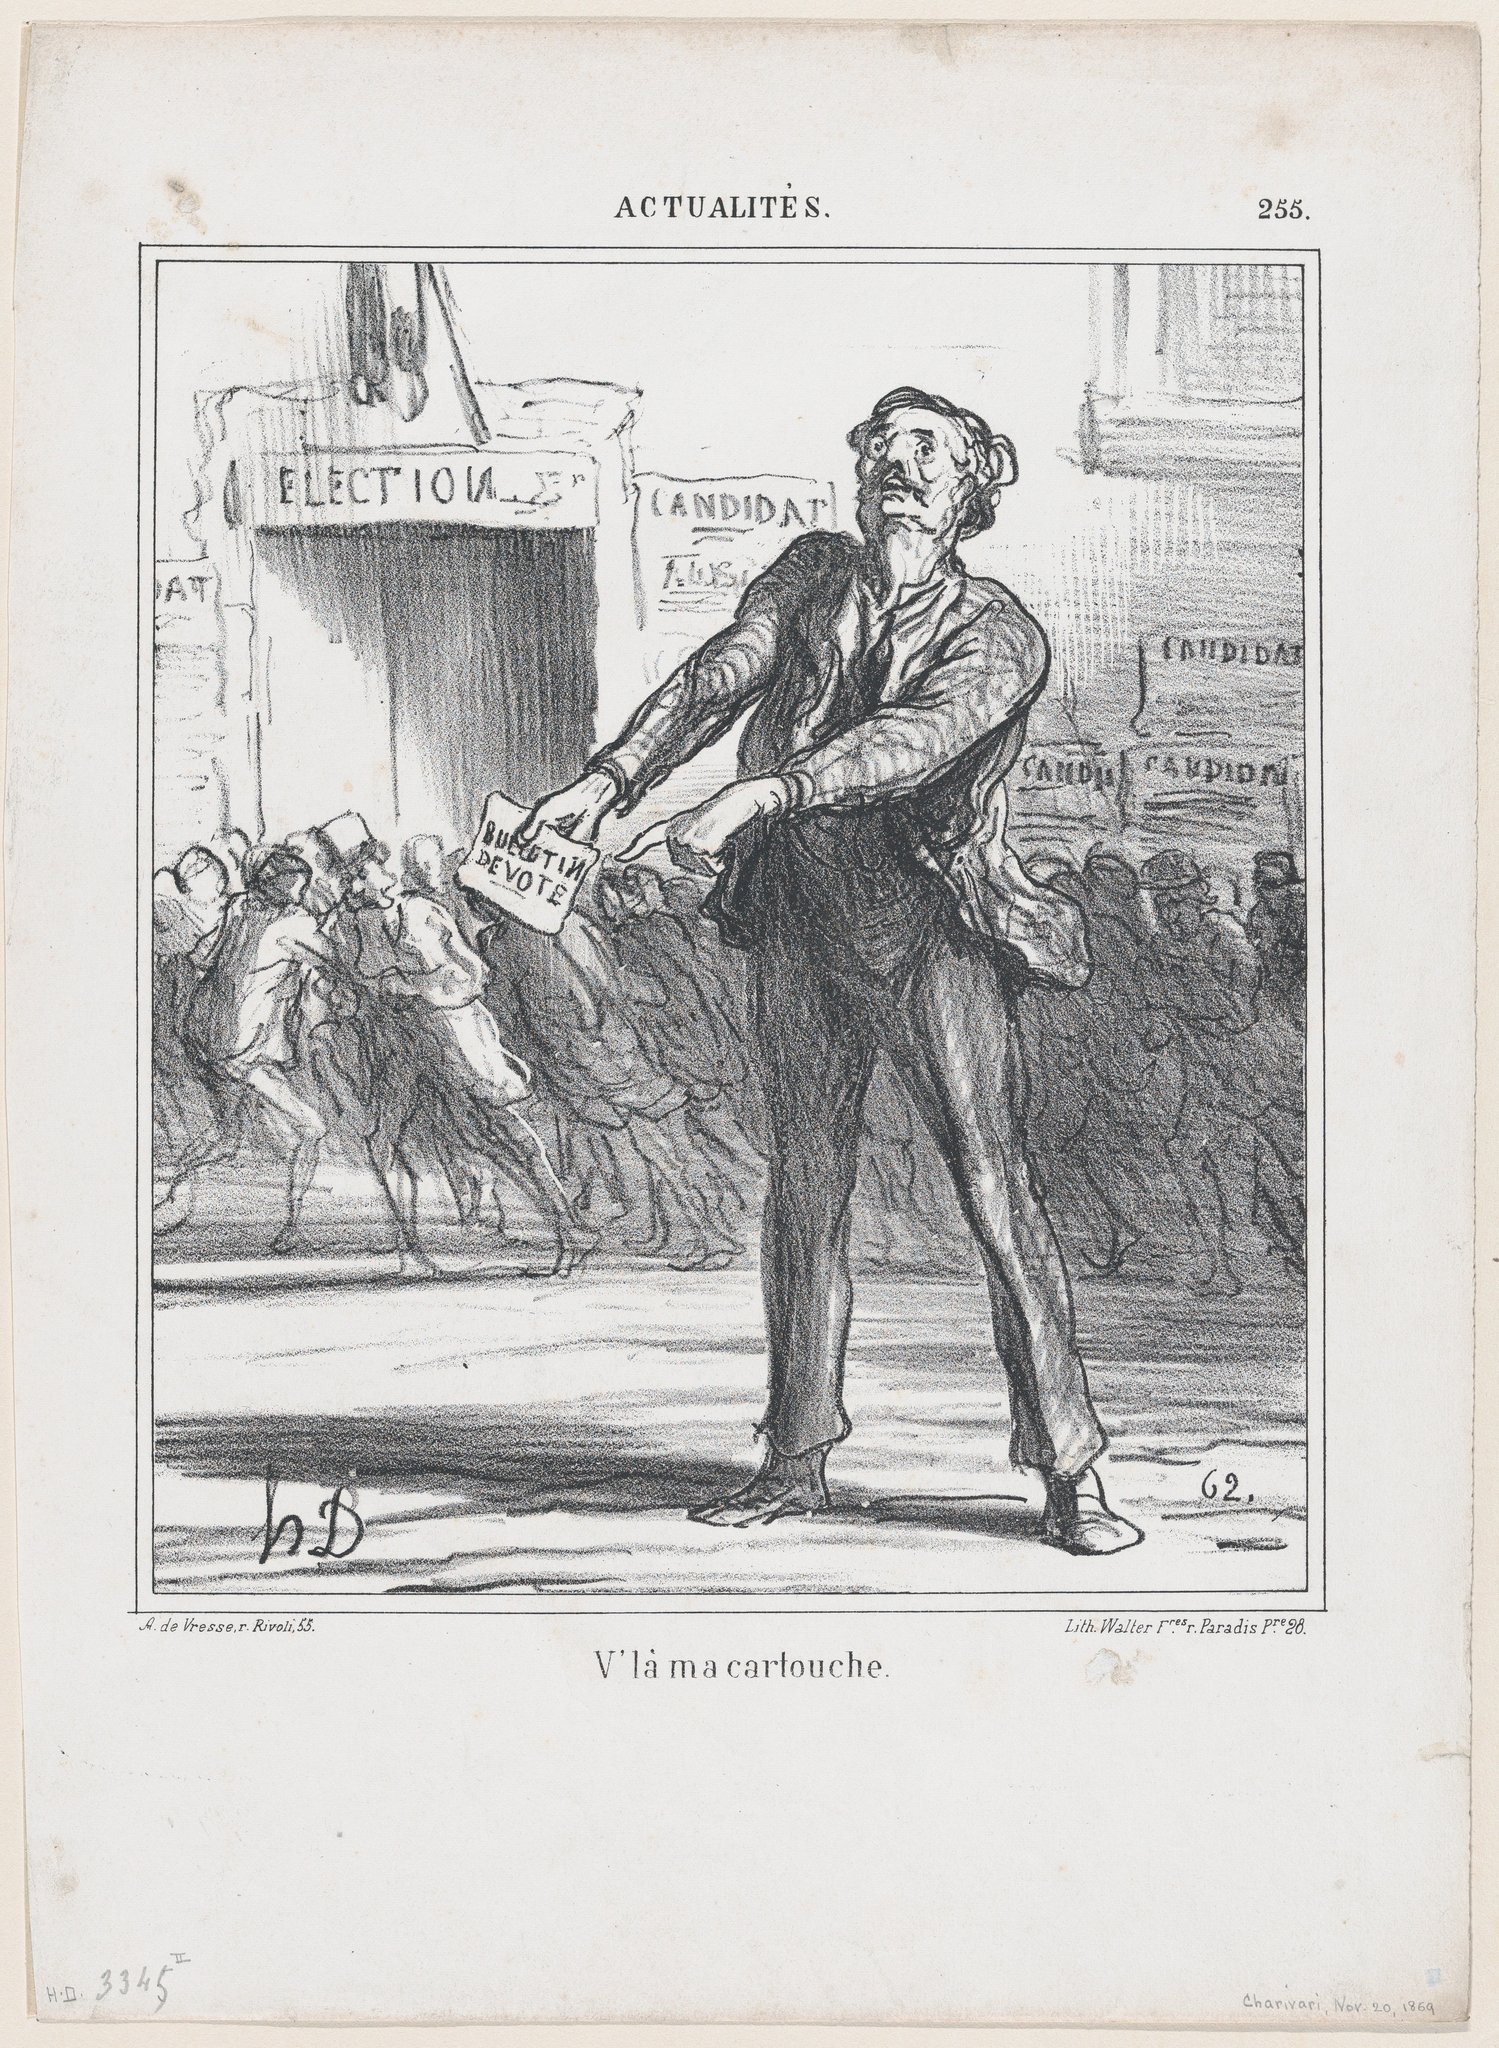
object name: print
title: This is my "bullet," from 'News of the day,' published in "Le Charivari"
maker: honoré daumier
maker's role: artist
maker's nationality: french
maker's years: 1808-1879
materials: paper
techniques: lithograph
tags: satire,men